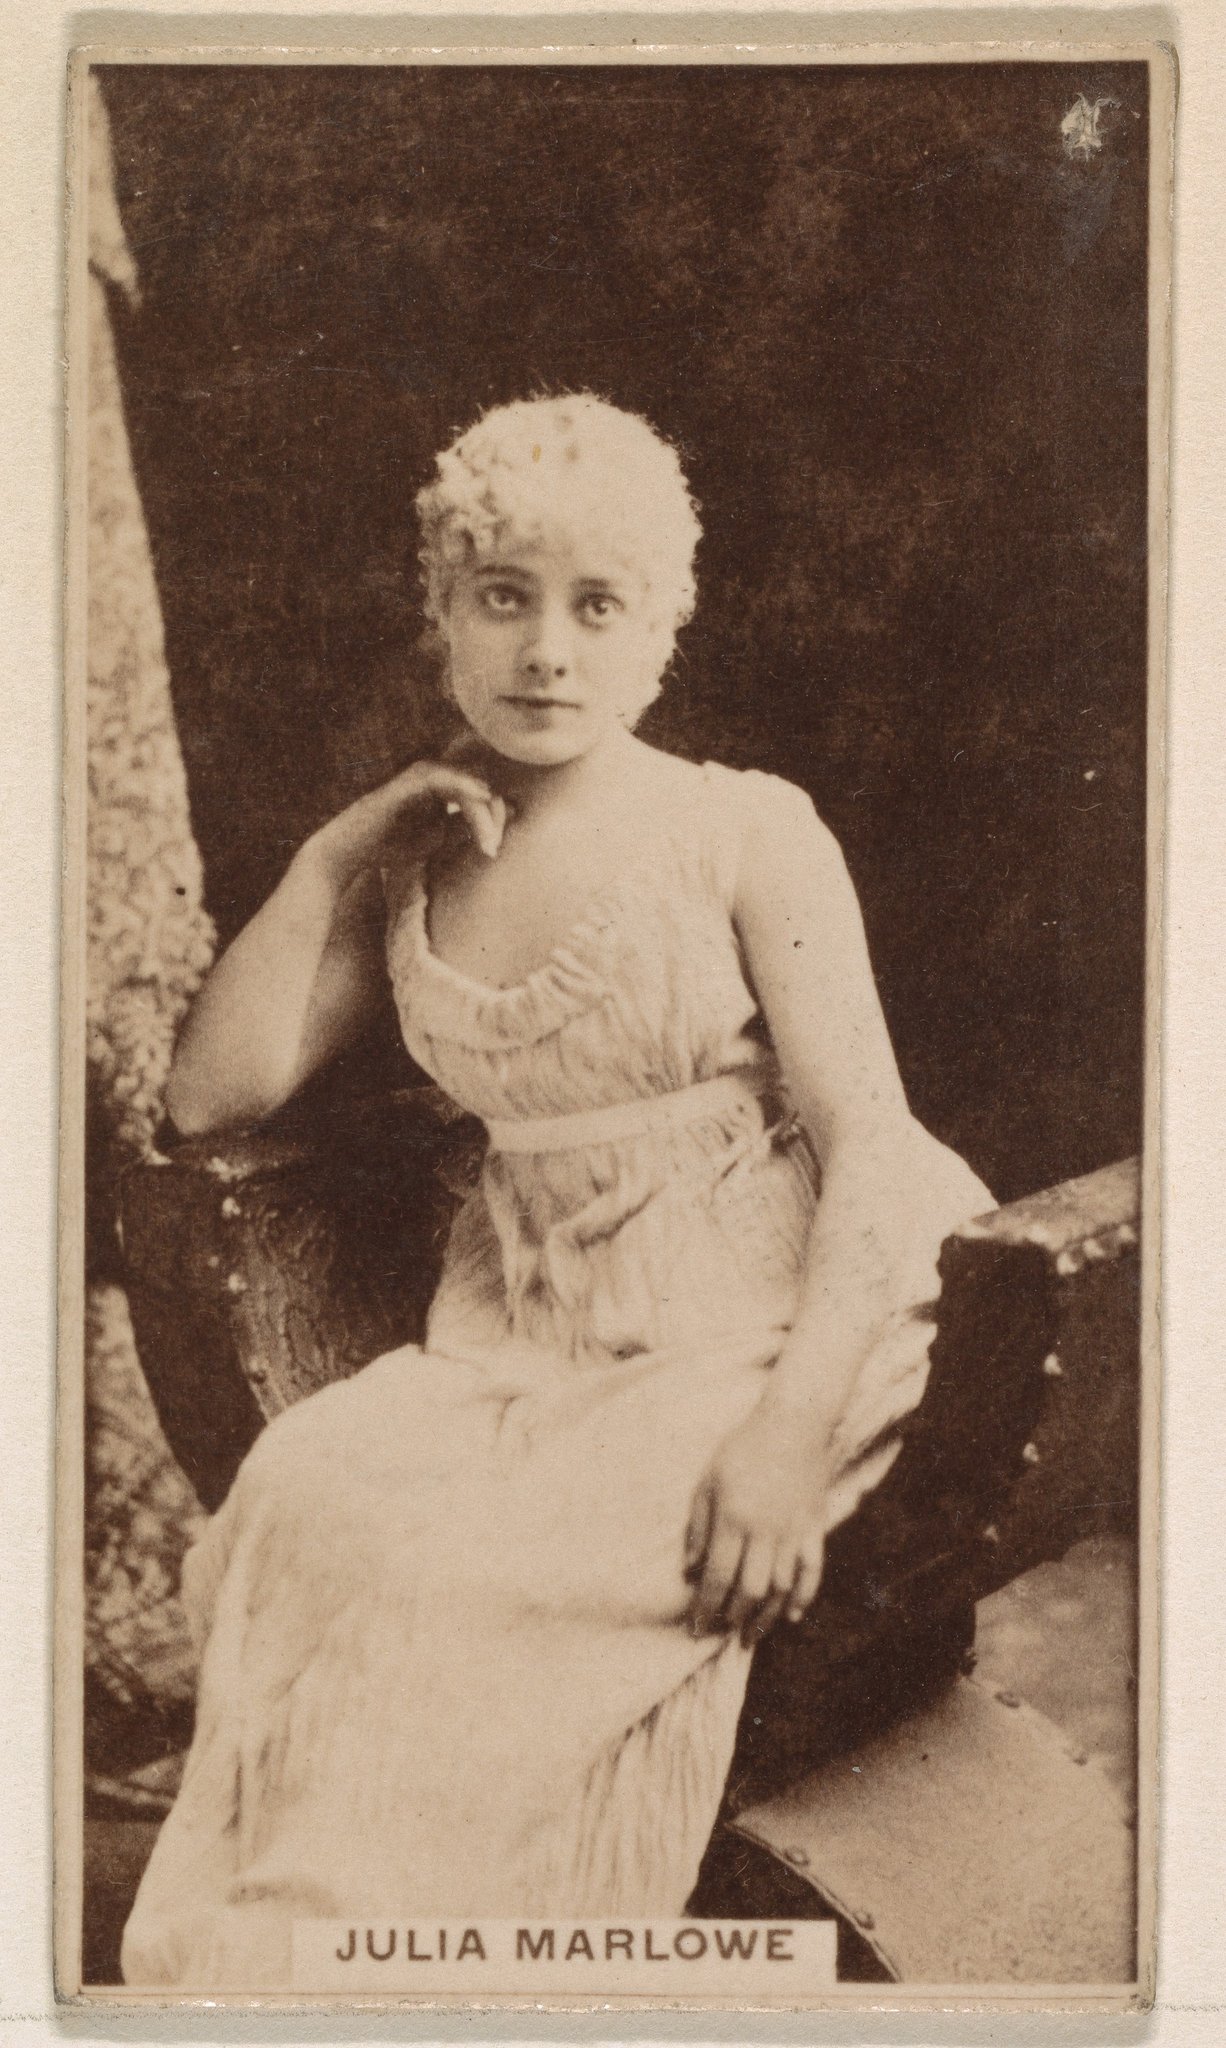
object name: photograph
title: Julia Marlow, from the Actresses series (N245) issued by Kinney Brothers to promote Sweet Caporal Cigarettes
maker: kinney brothers tobacco company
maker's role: publisher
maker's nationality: american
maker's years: 1869-2011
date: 1890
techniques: albumen silver print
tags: portraits,women,actresses